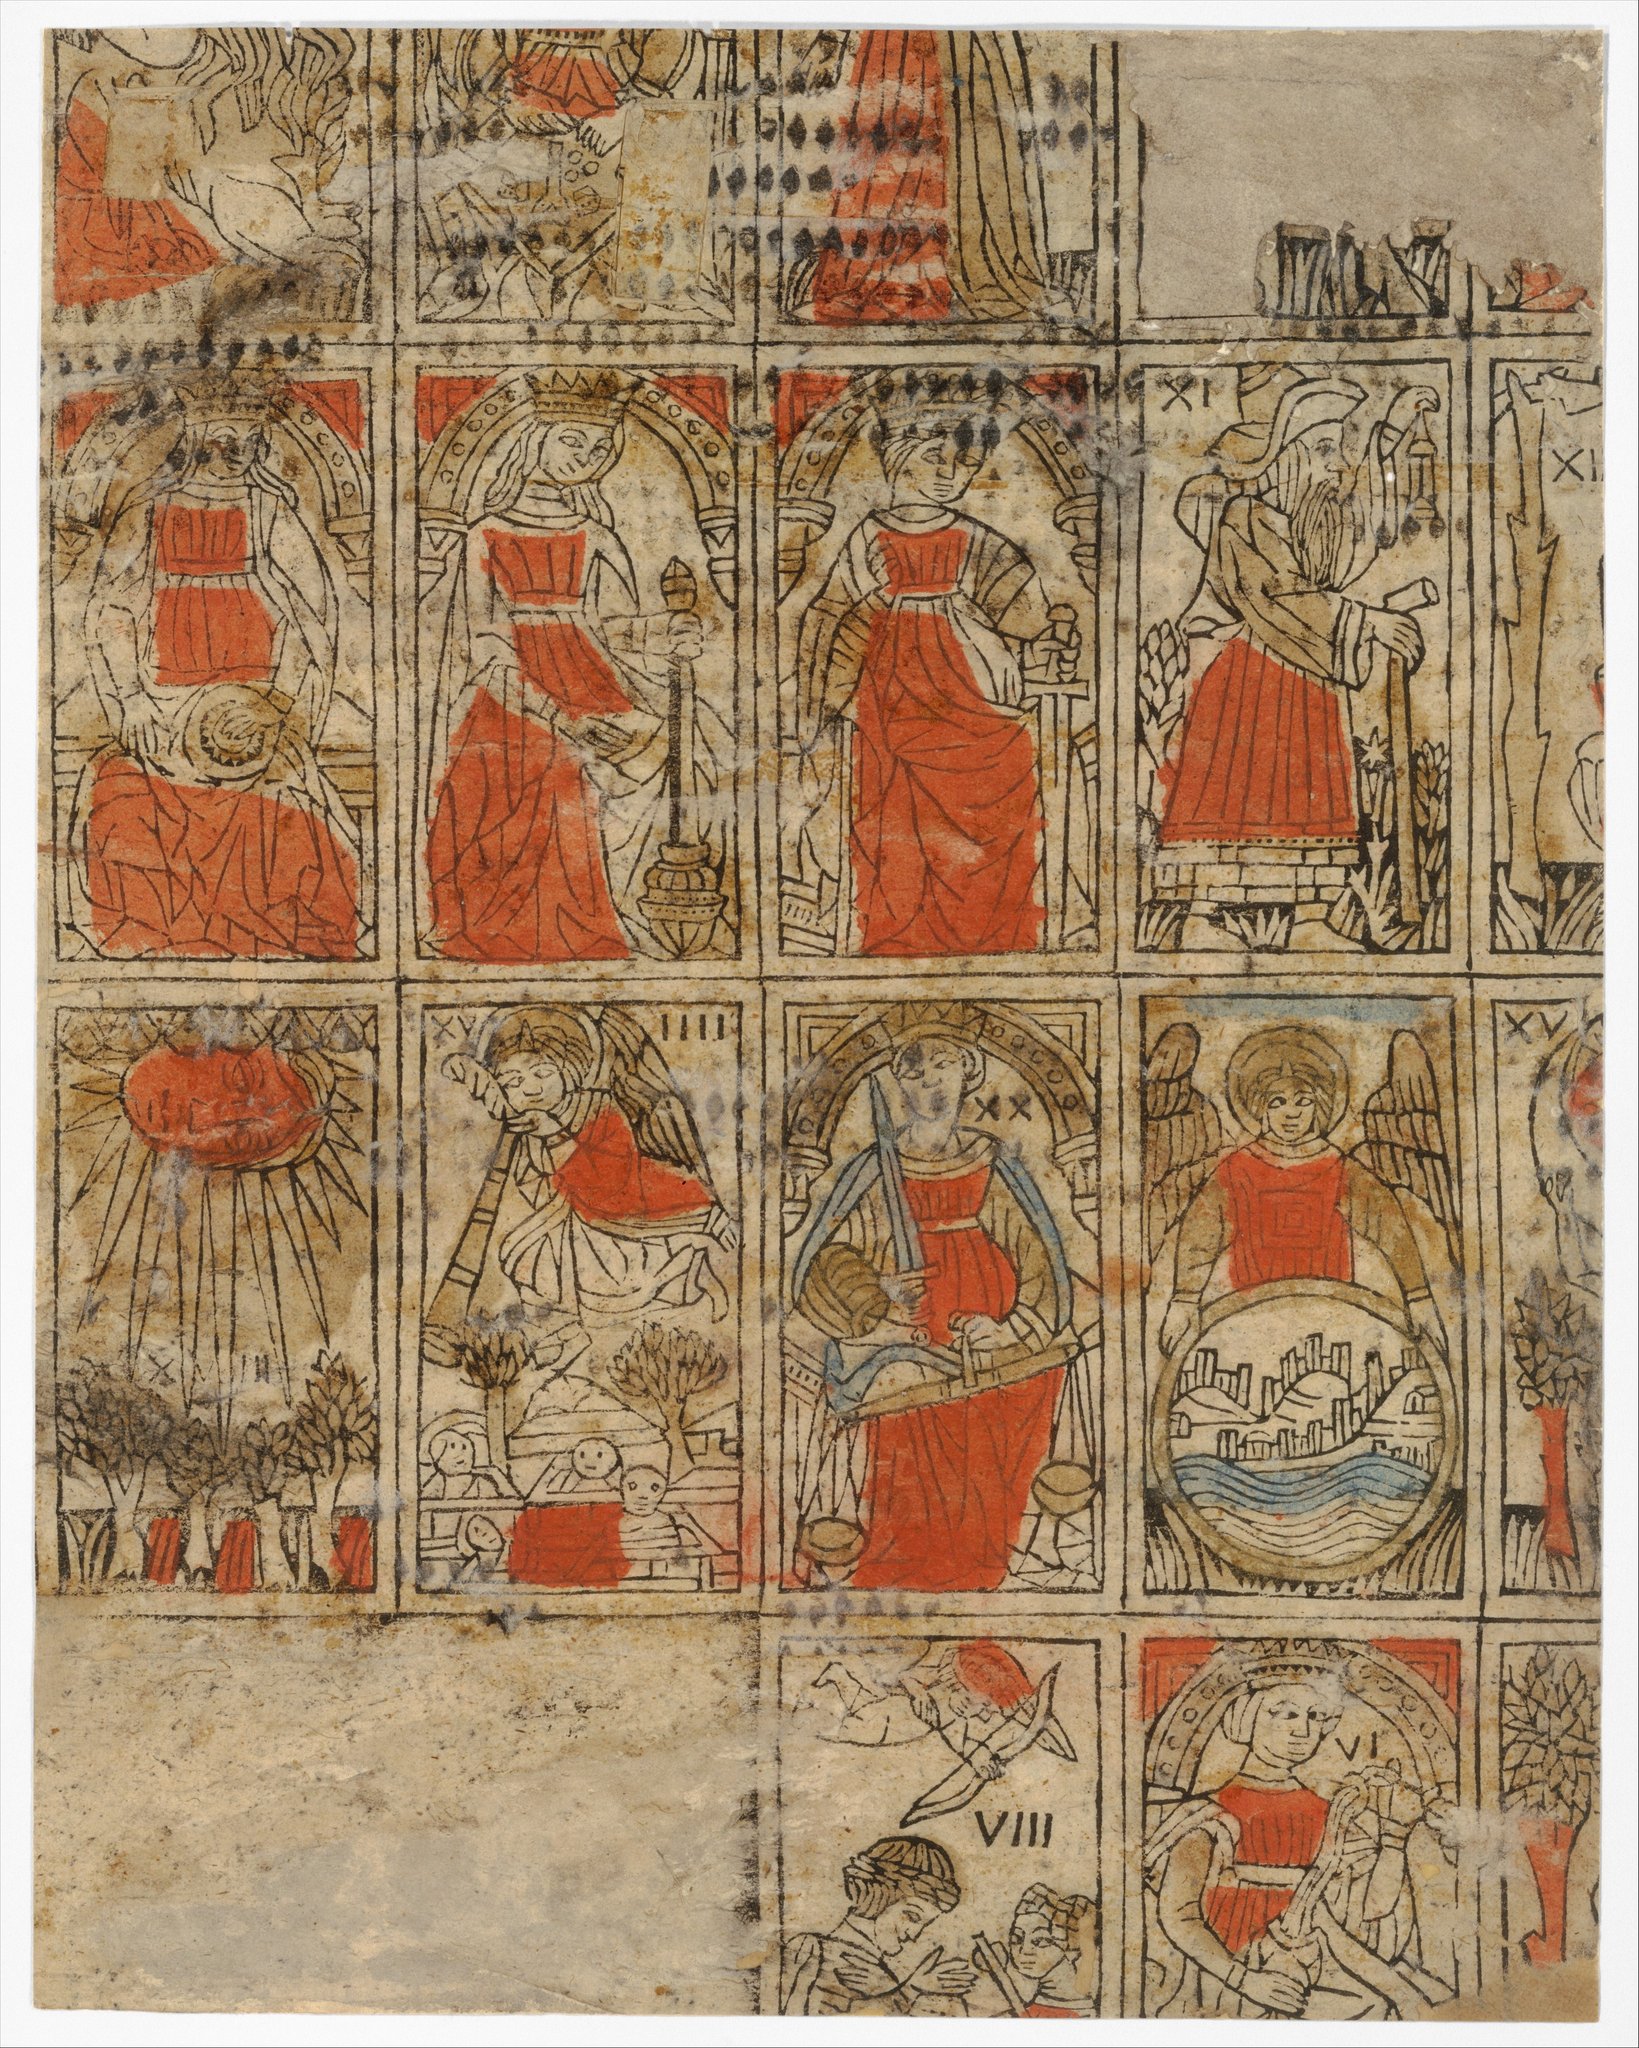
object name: print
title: Tarocchi Cards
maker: anonymous, italian, 15th to 16th century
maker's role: artist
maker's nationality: italian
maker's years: 1400-1700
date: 1500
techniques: pochoir, woodcut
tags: playing cards,games